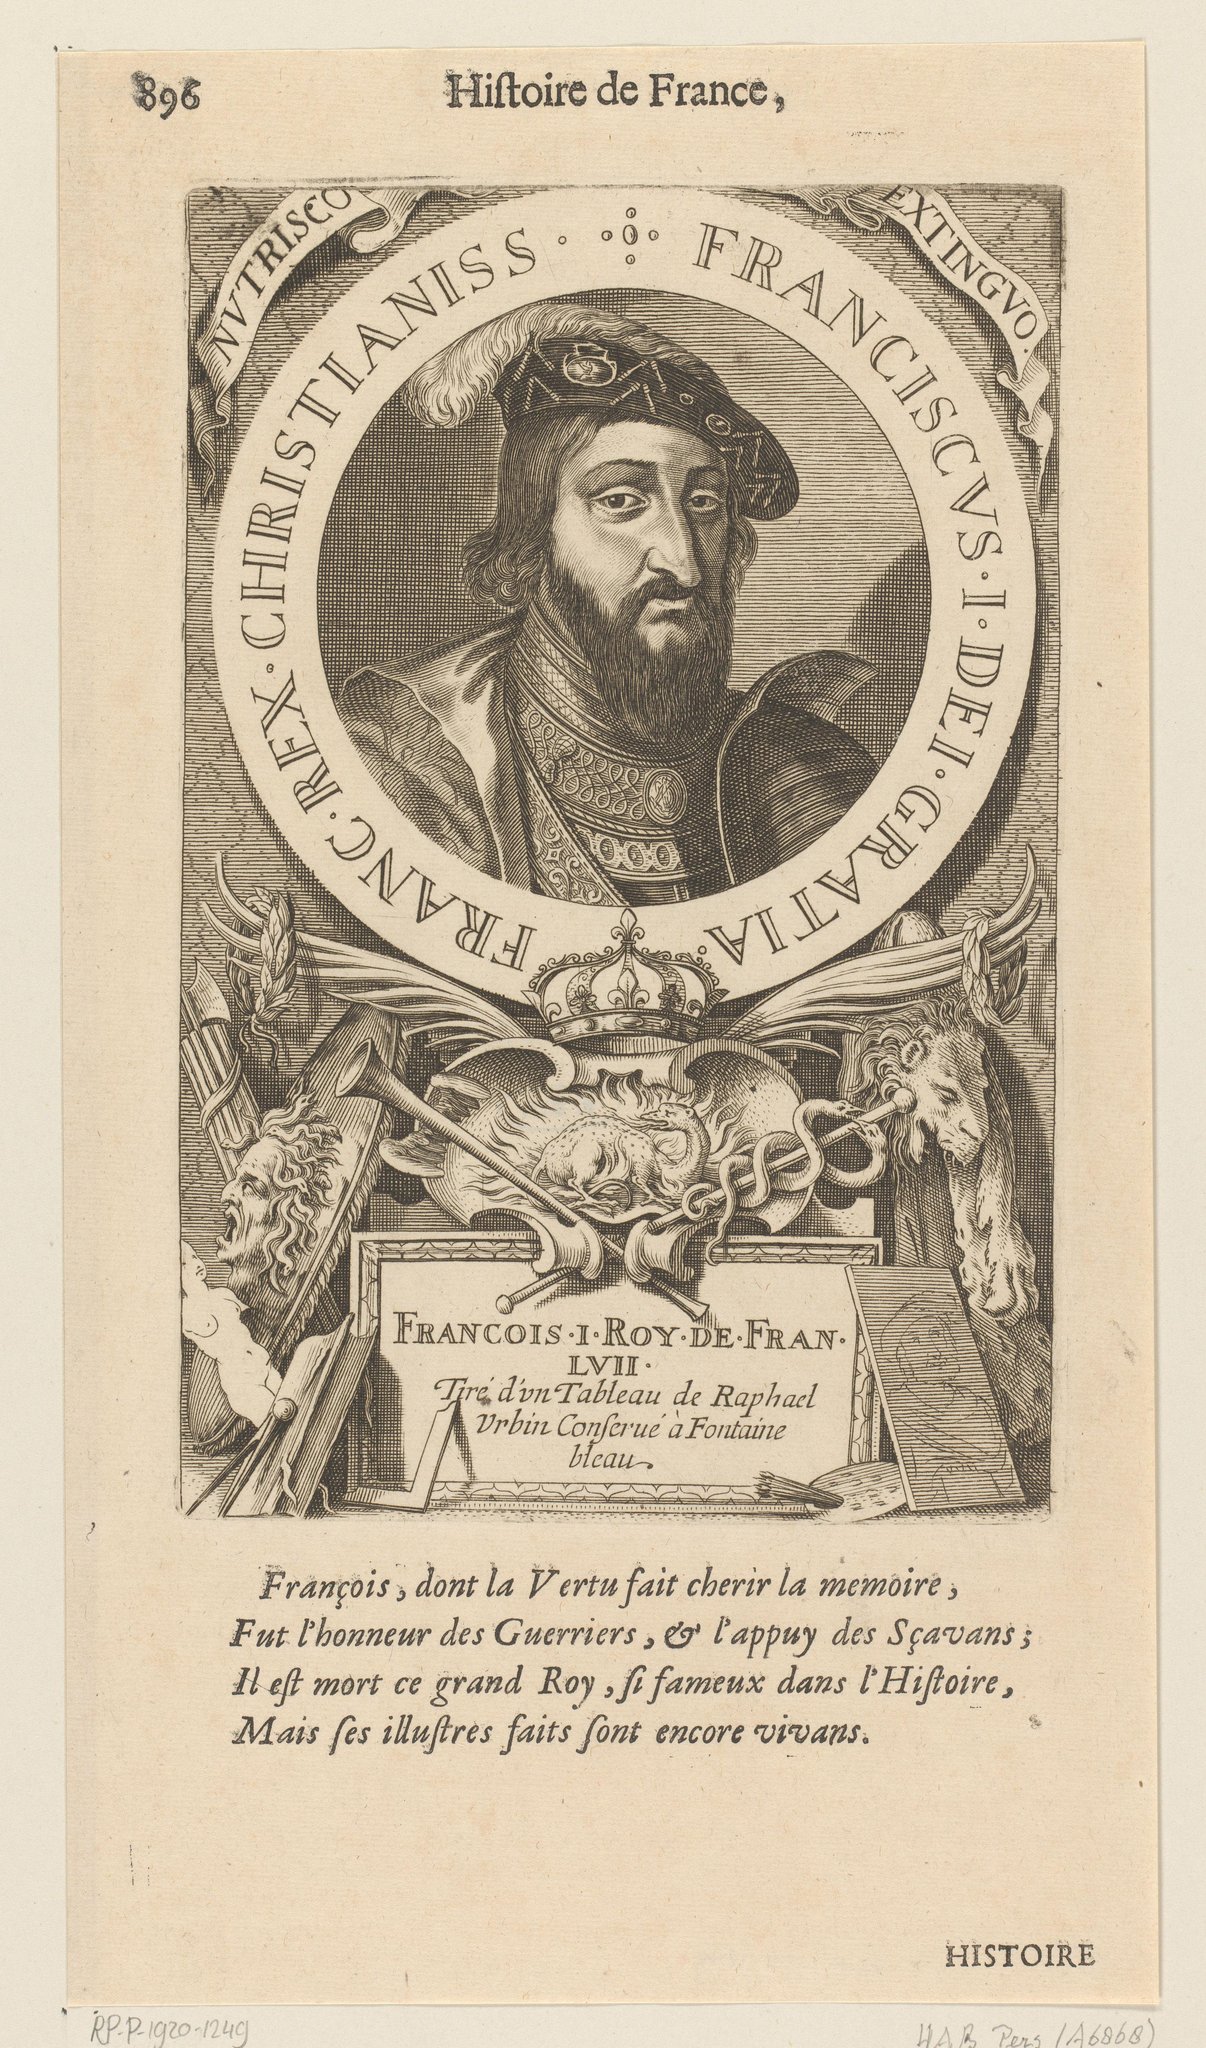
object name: print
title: Francois I roy de France LVII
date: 1635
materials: paper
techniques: engraving, letterpress printing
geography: paris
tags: frans i van valois-angoulême (koning van frankrijk), historical persons, ruler, sovereign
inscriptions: collector's mark: Lugt 2228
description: Prent uit: Eudes de Mézeray, François. Histoire de France, depuis Faramond jusqu’au regne de Louis le Juste (...). 3 dln. Parijs: Denis Thierry, Jean Guignard en Claude Barbin, 1635, dl. 2. Prent waarschijnlijk voor het eerst verschenen in: Bie, Jacques de. Les vrais portraits des rois de France (...). Parijs: Jacques de Bie en Pierre Rocolet, 1634. Prent ook gebruikt in latere publicaties.